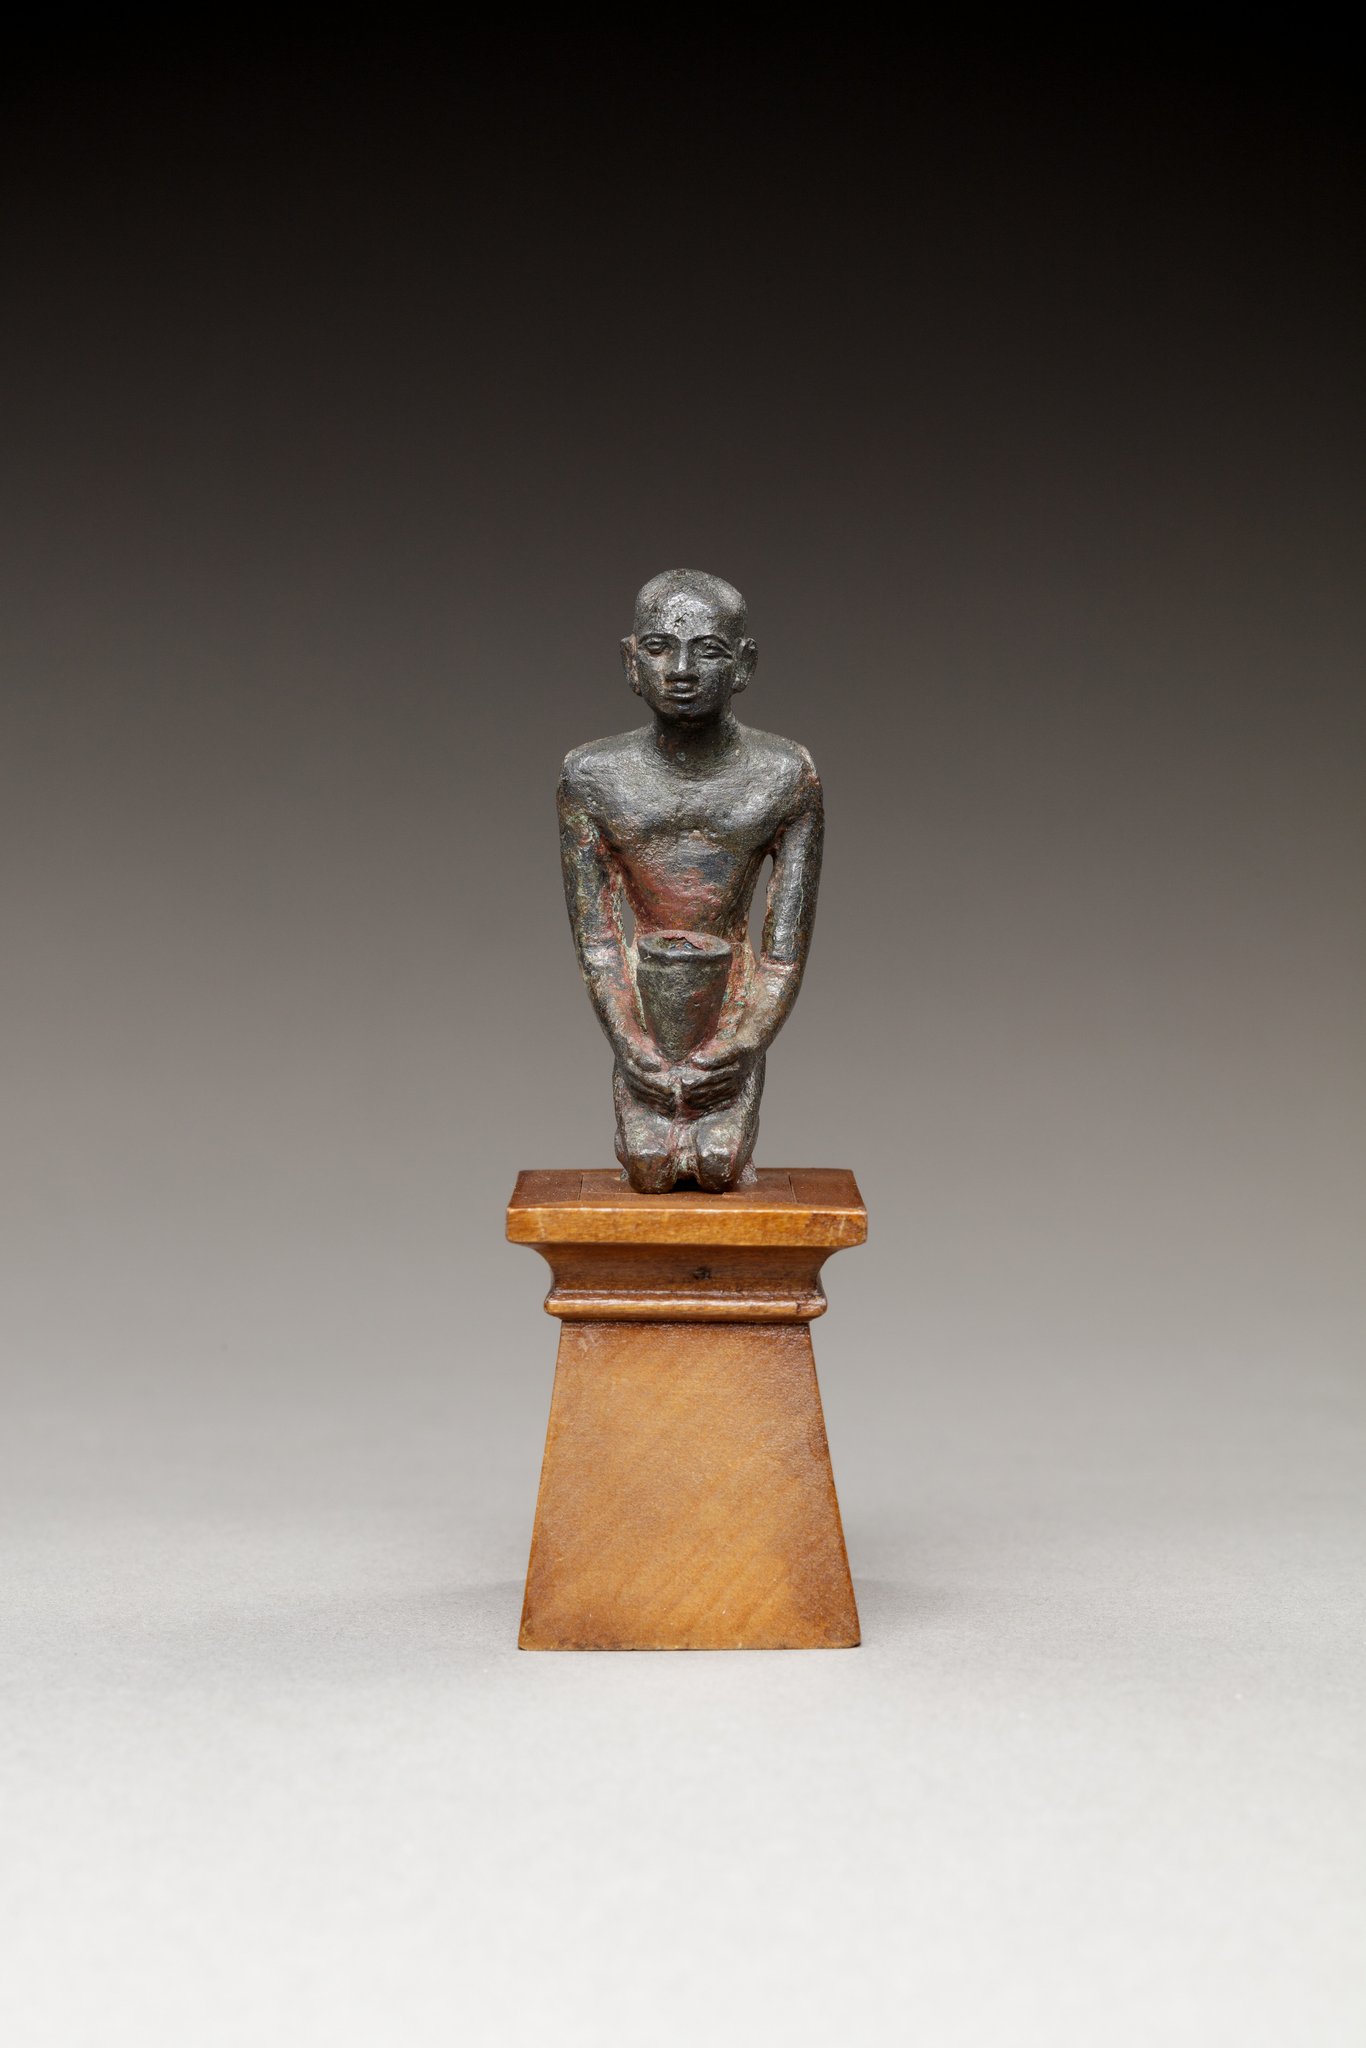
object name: priest, jar, kneeling, pediuser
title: Pediusir kneeling, holding a jar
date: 664-200 BCE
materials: copper alloy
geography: egypt